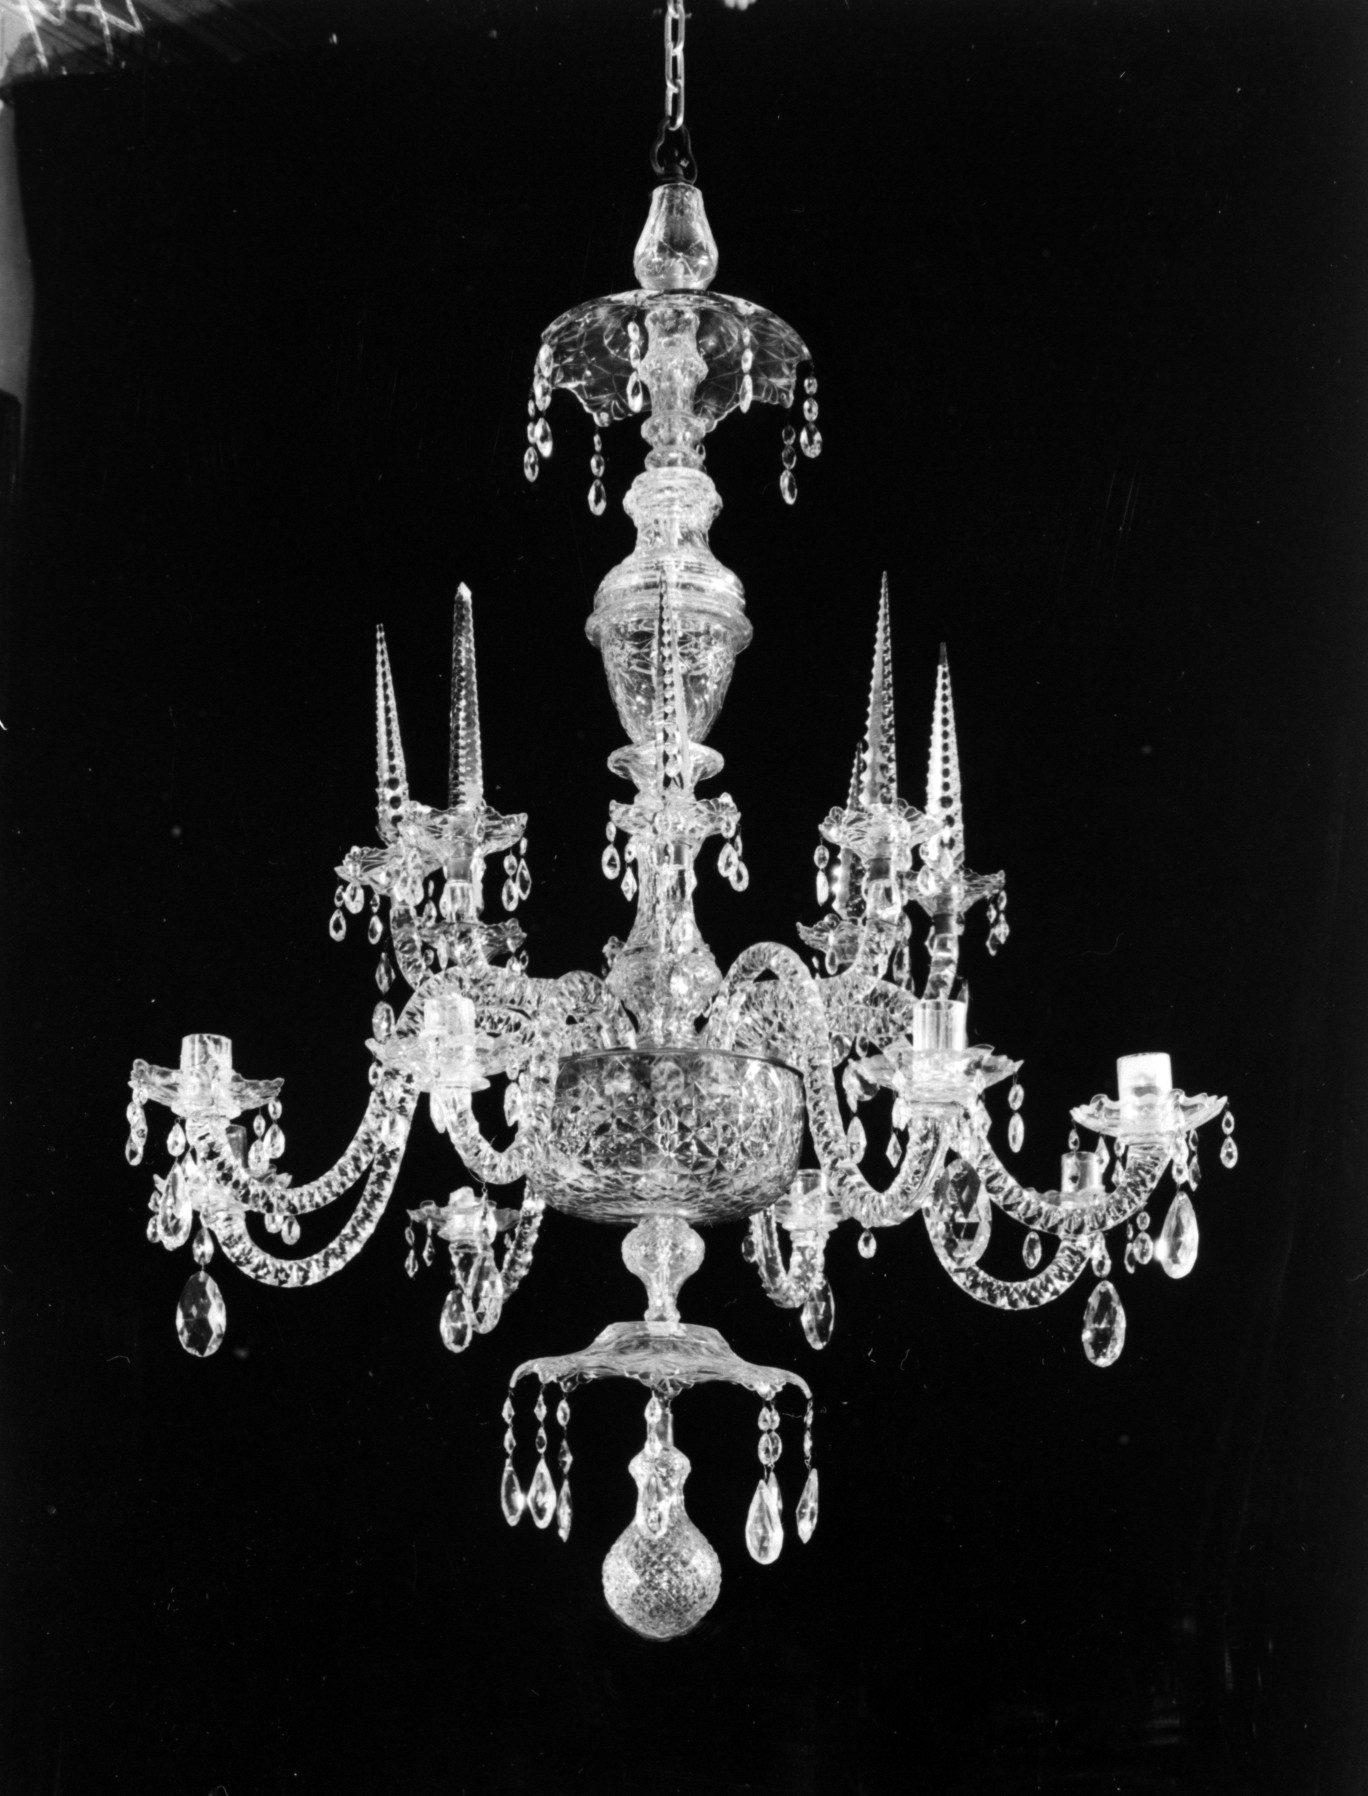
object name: chandelier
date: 1775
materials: glass